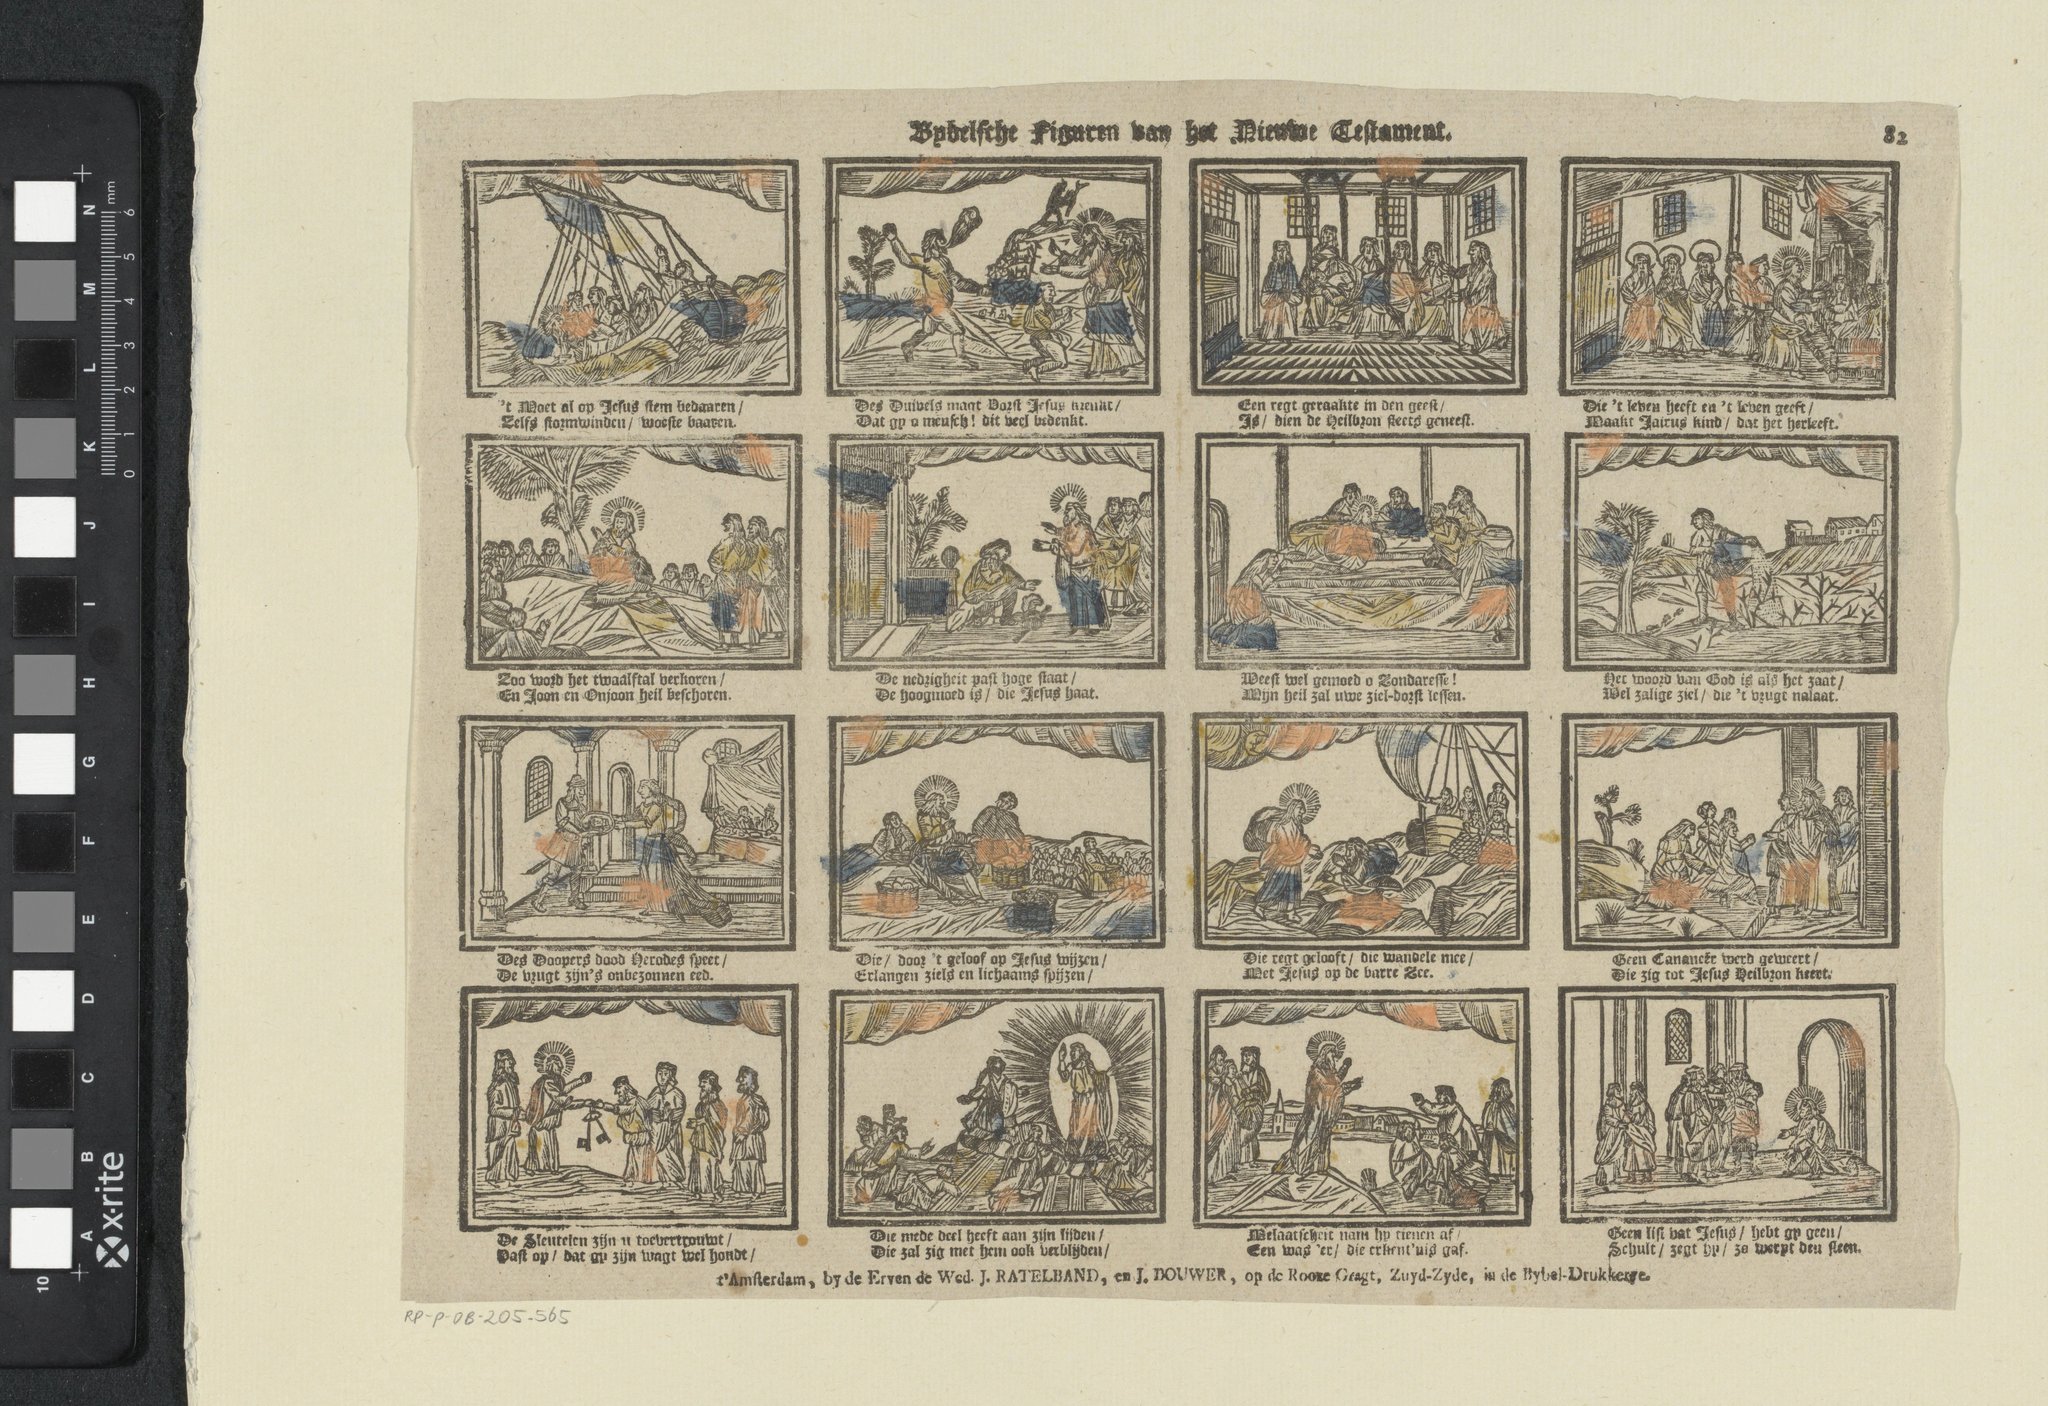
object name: popular print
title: Bybelsche figuren van het Nieuwe Testament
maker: Anonymous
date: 1782-1893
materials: paper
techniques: colour, letterpress printing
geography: amsterdam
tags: new testament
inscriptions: collector's mark: Lugt 2760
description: Blad met 16 voorstellingen van verhalen uit het Nieuwe Testament. Onder elke afbeelding een tweeregelig vers. Genummerd rechtsboven: 82.